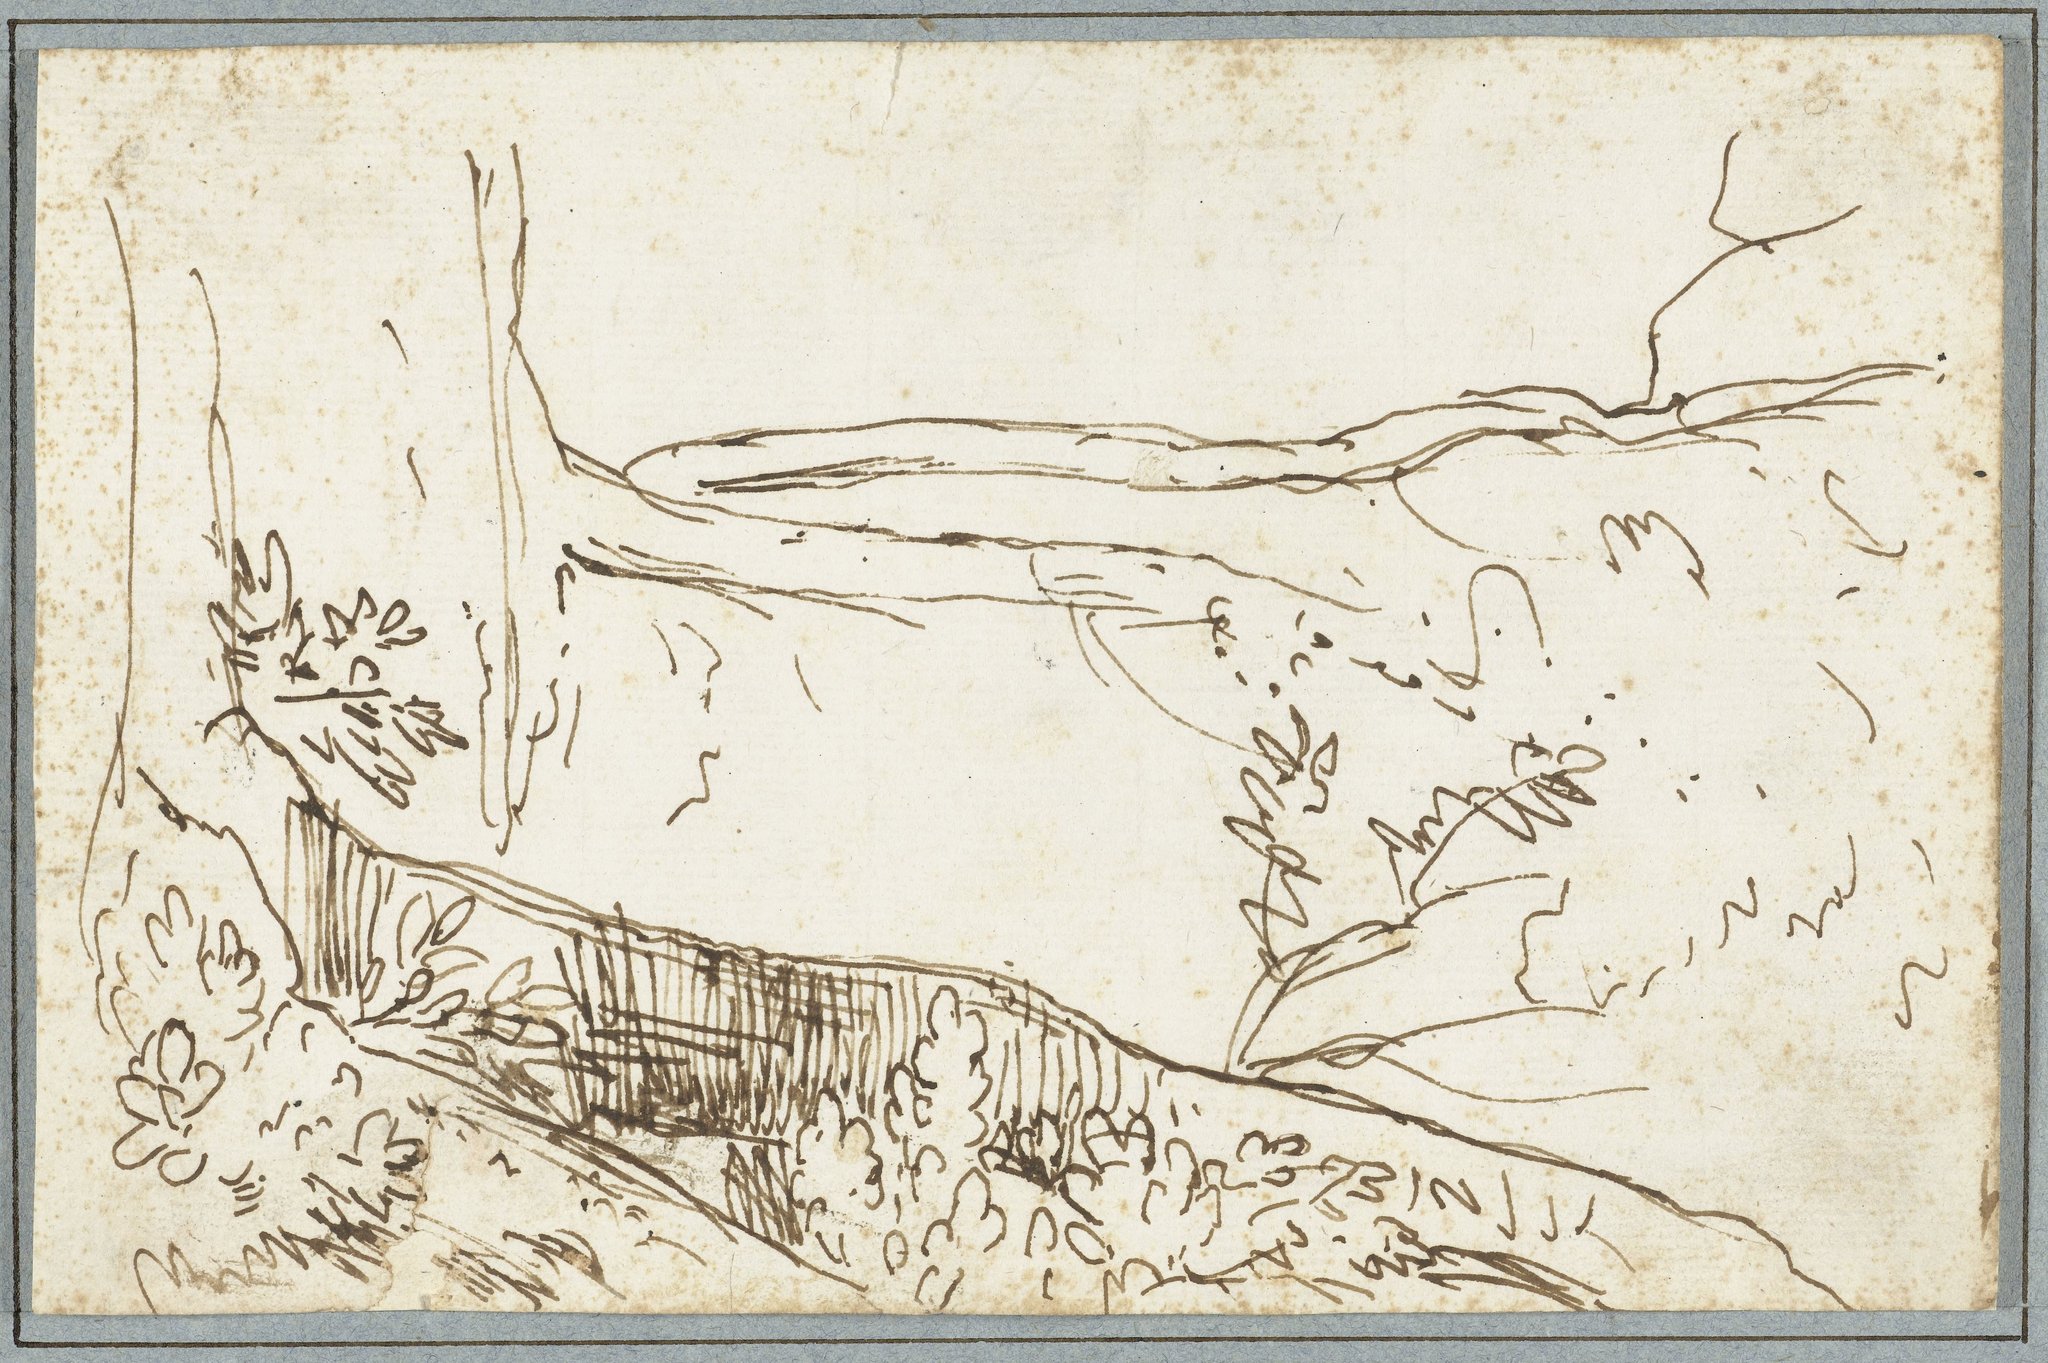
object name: drawing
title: Studie van twee bomen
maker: claude lorrain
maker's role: draughtsman, print maker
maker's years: 1604-1682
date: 1665-1670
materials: ink, paper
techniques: pen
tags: groups of trees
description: Studies van dieren uit het zogenaamde Dierenalbum.